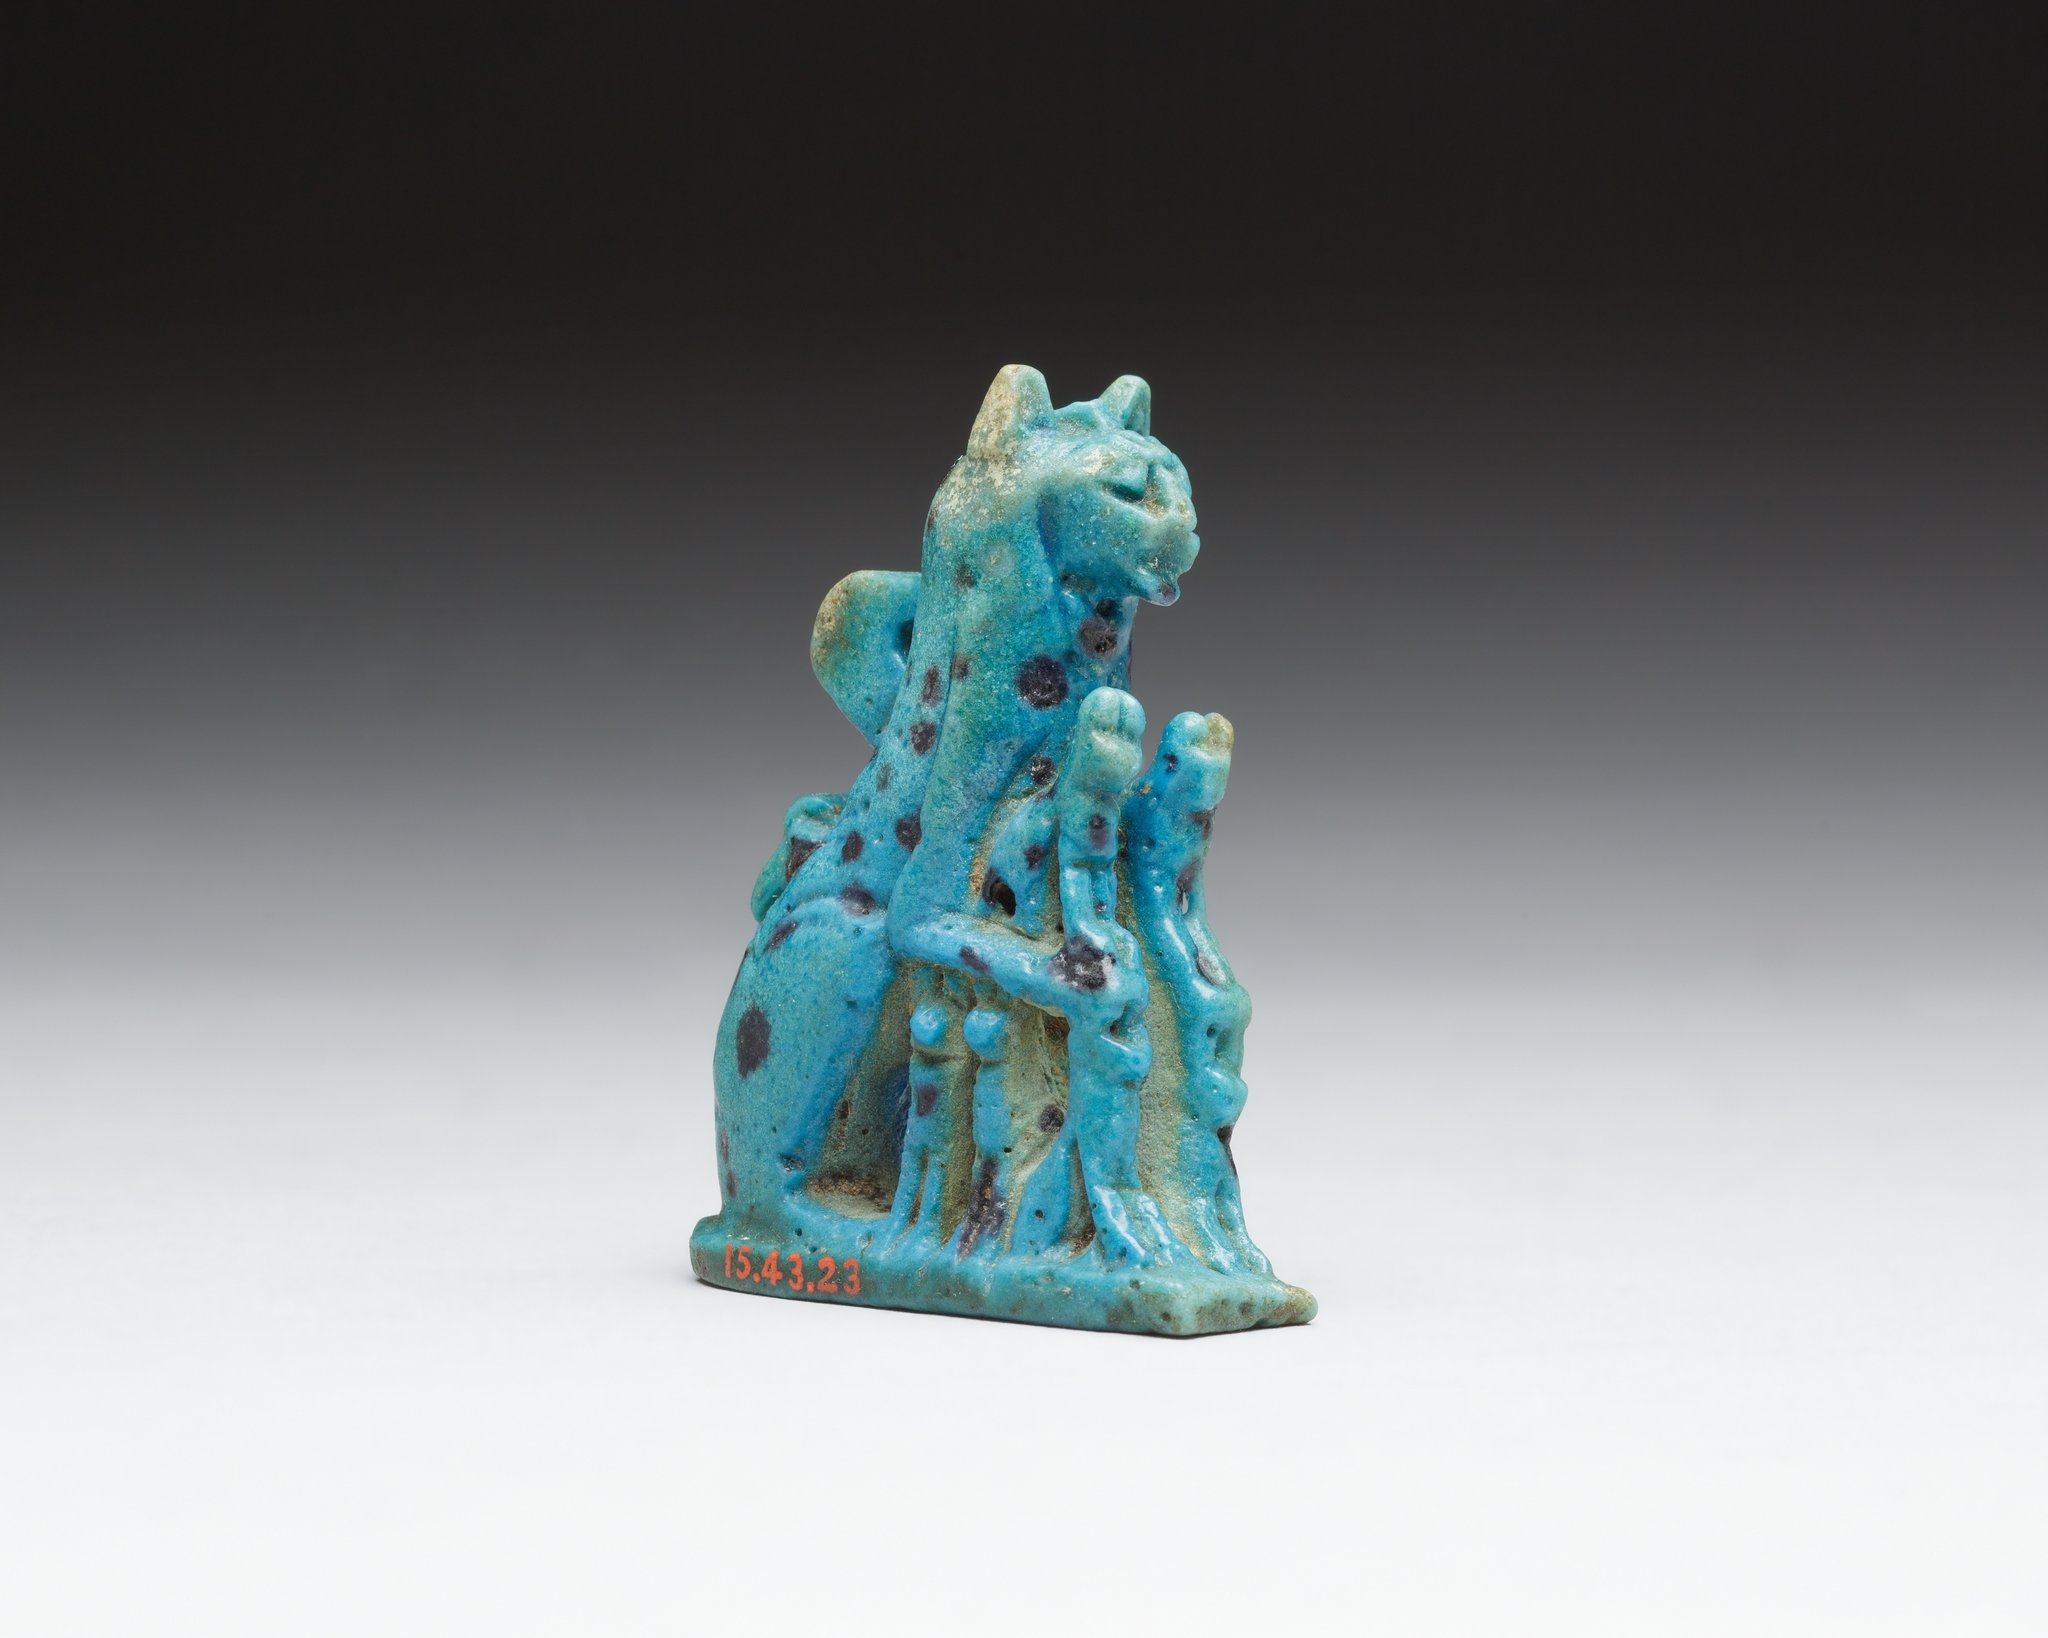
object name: amulet, cat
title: Cat amulet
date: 1070-664 BCE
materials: faience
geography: egypt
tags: cats